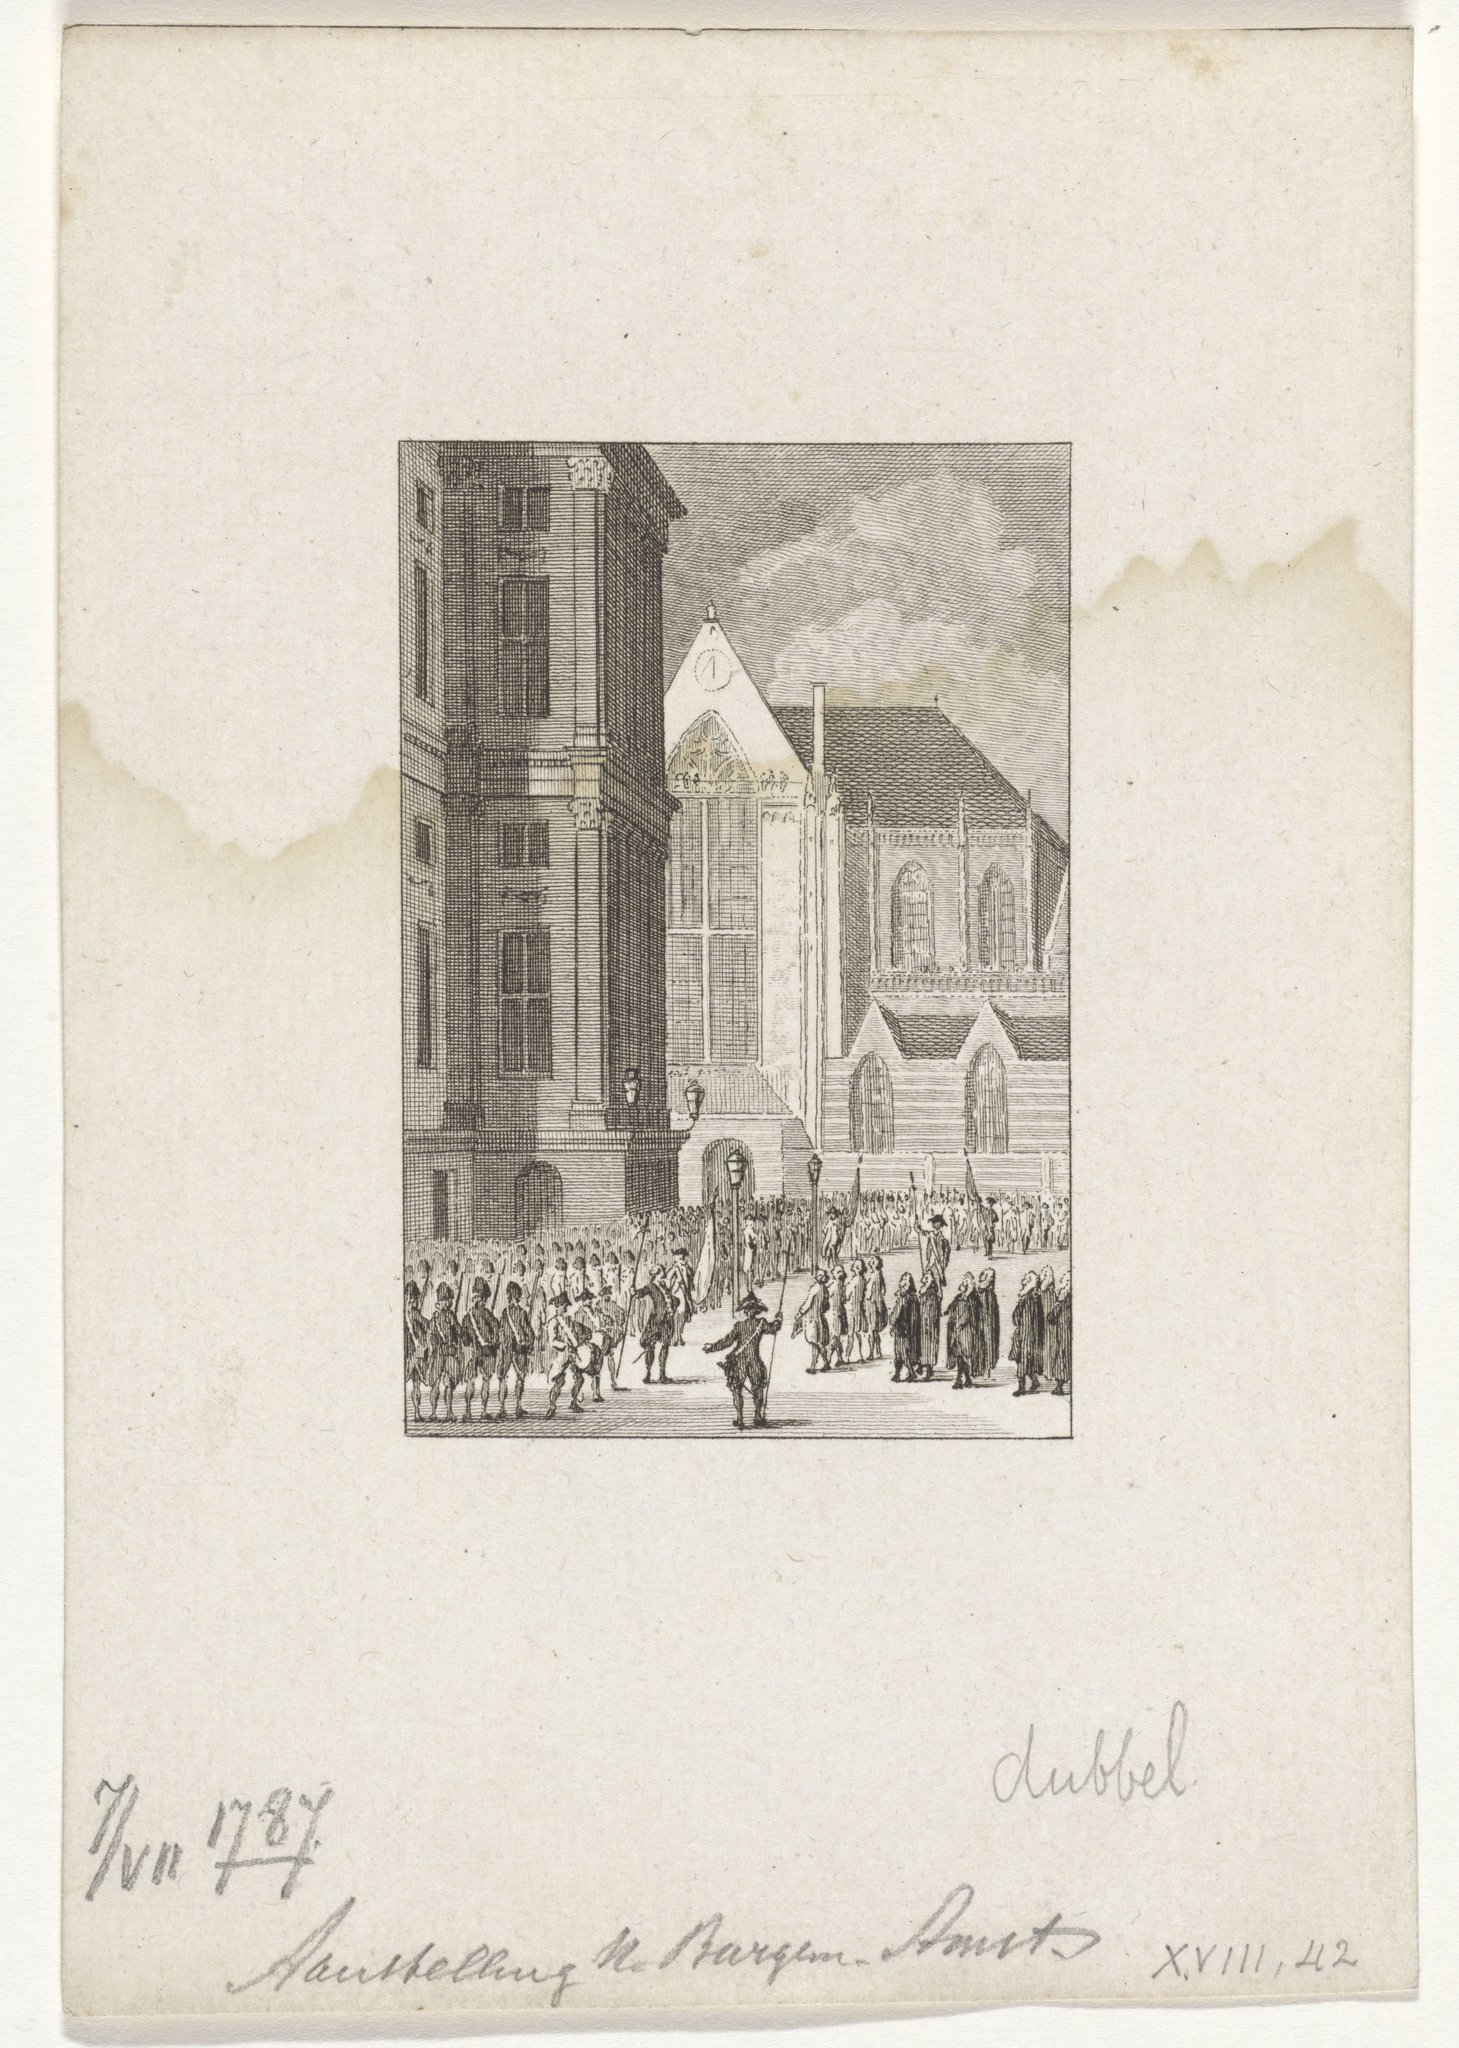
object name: history print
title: Aanstelling van twee nieuwe burgemeesters te Amsterdam, 1787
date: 1783-1795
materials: paper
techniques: etching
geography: amsterdam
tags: nieuwe kerk, dam, stadhuis van amsterdam (1655-1808), herstel van stadhouder willem v (1787)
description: Illustratie voor: J. Fokke. Geschiedenissen der Vereenigde Nederlanden voor de vaderlandsche jeugd. Amsterdam: Johannes Allart, 1783-1795, 25 delen. deel XVIII pl. I.